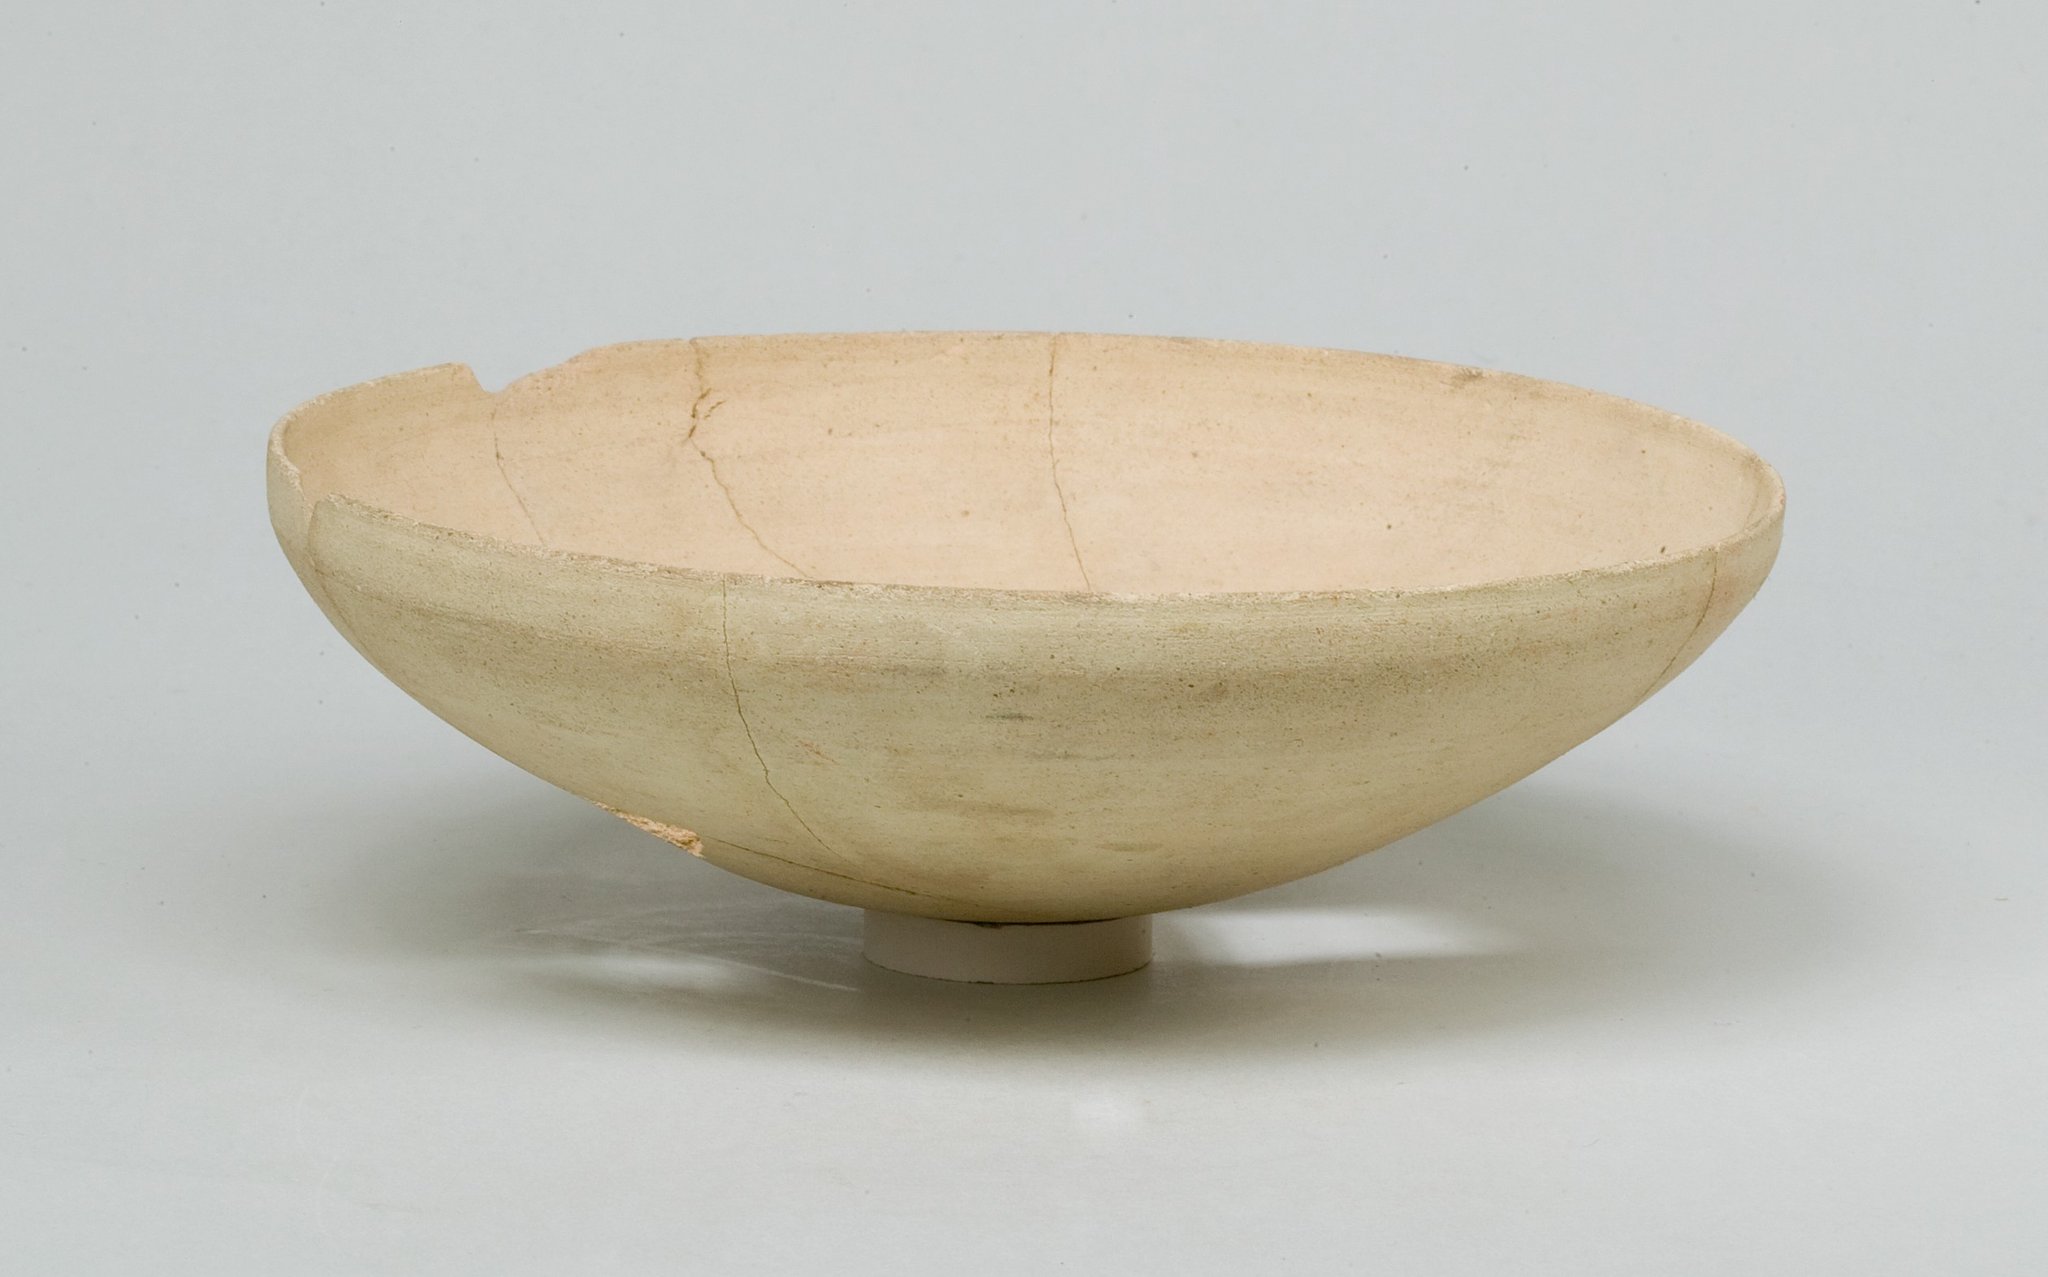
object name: dish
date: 1550-1295 BCE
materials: stone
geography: egypt